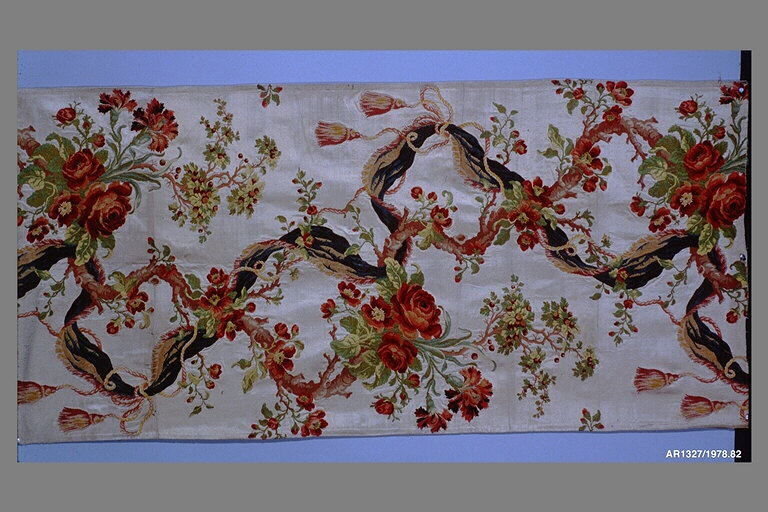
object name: length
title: Length of upholstery silk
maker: philippe de lasalle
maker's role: designer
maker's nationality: french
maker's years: 1723-1804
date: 1760-1765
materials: silk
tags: roses